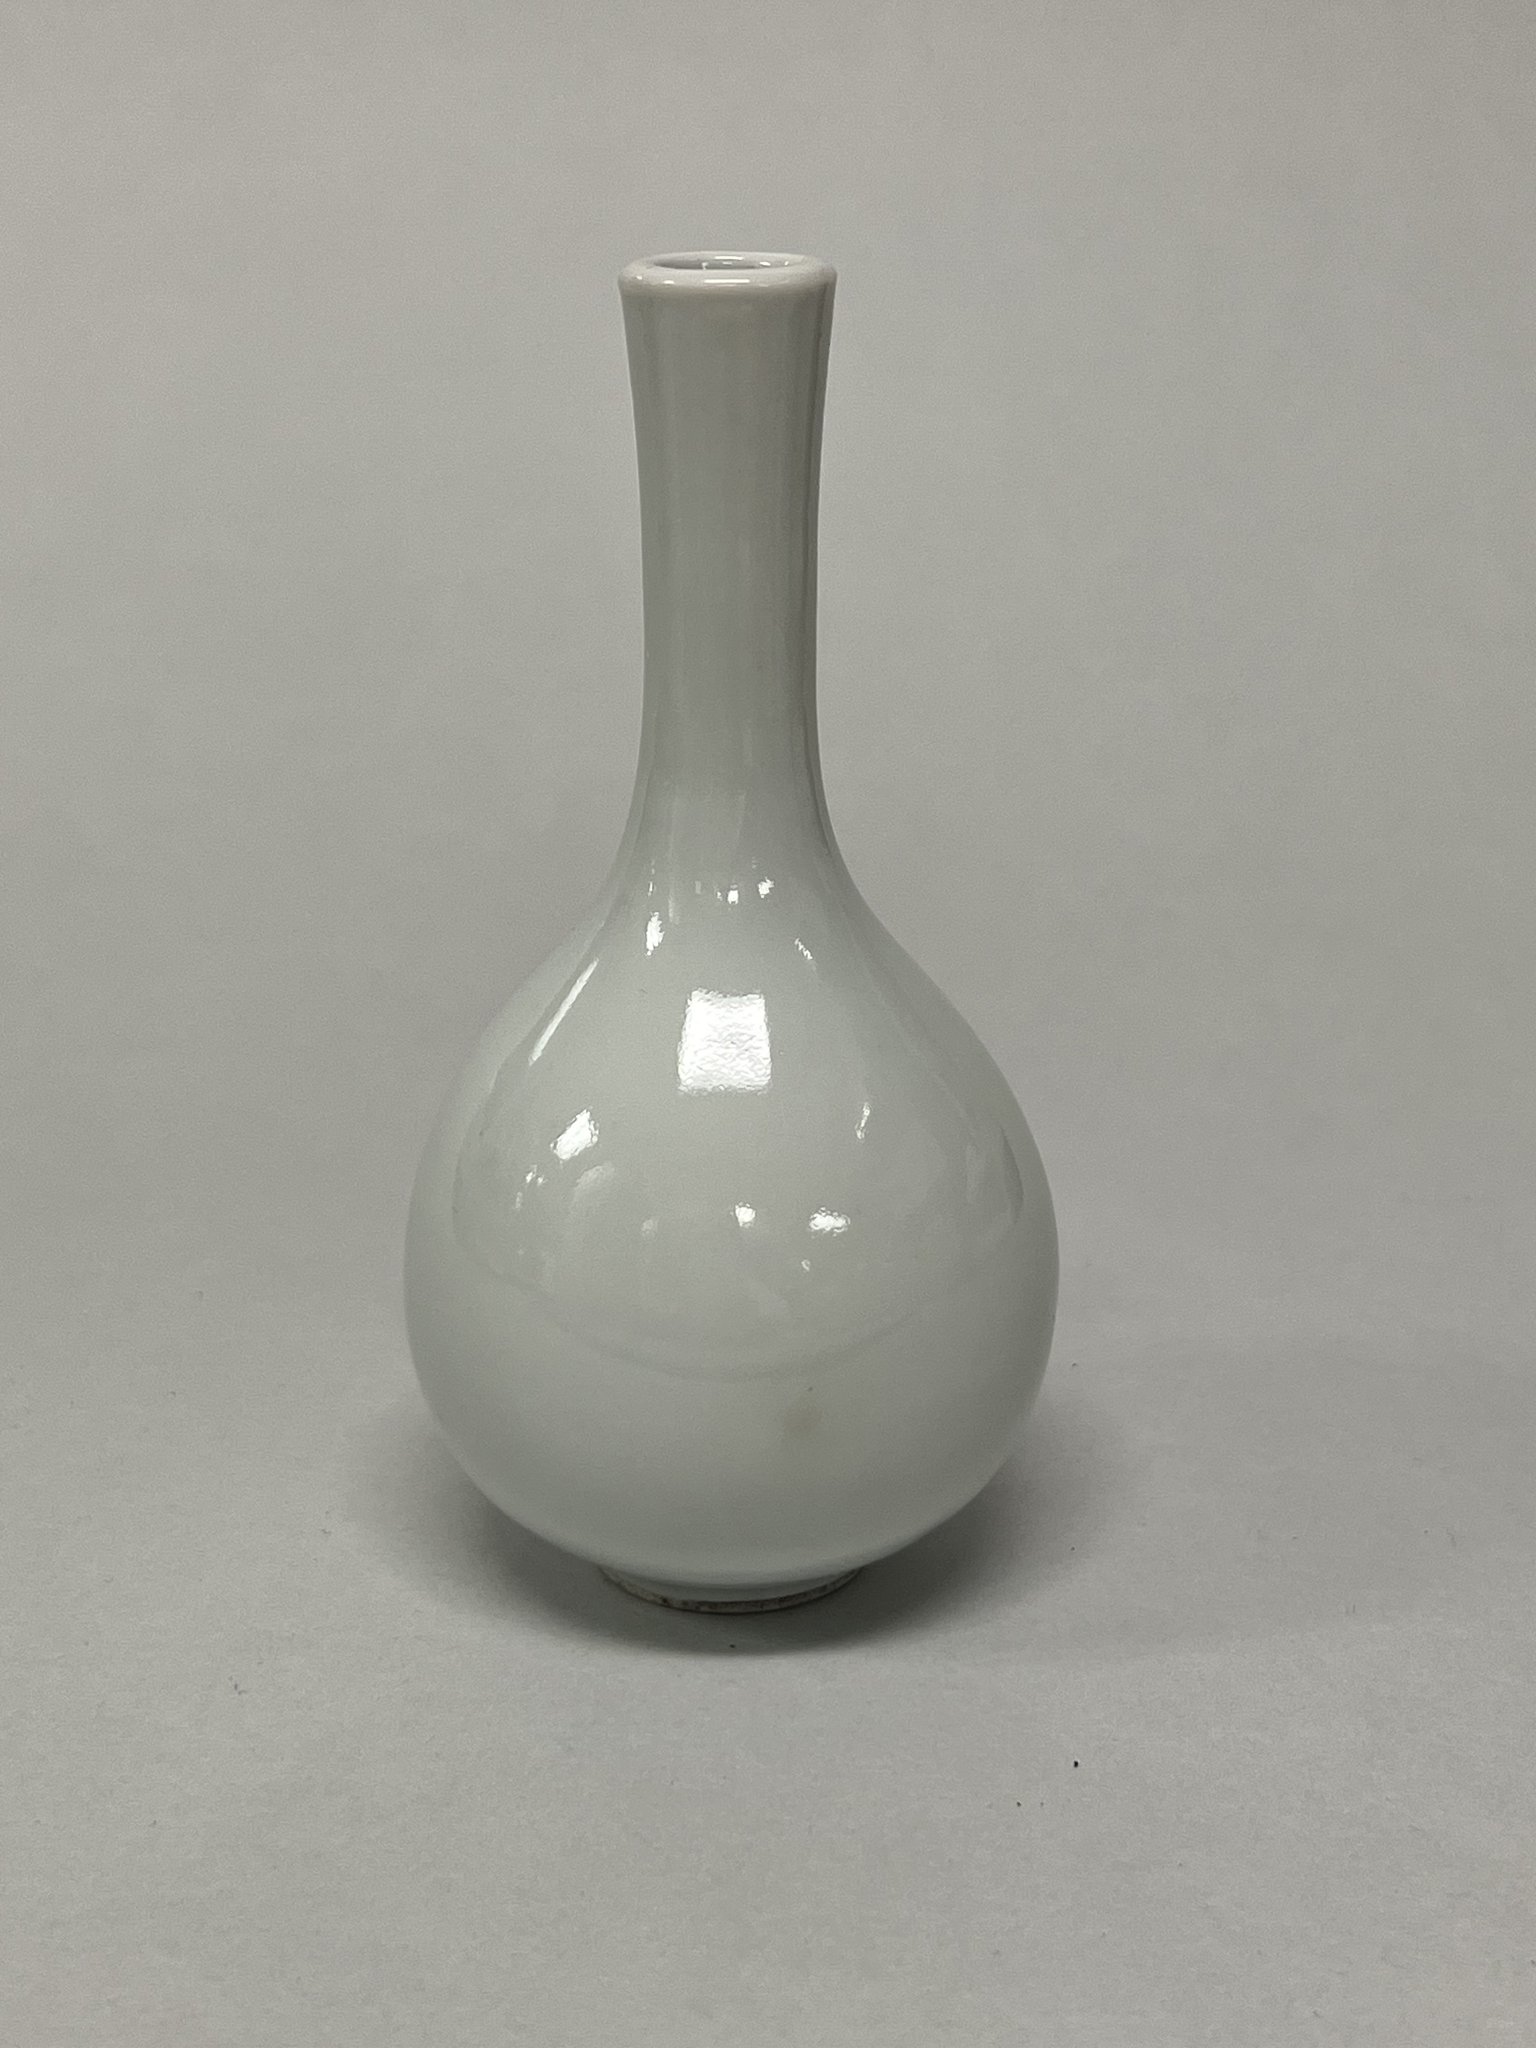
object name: bottle vase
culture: chinese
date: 1701-1800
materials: glaze, porcelain